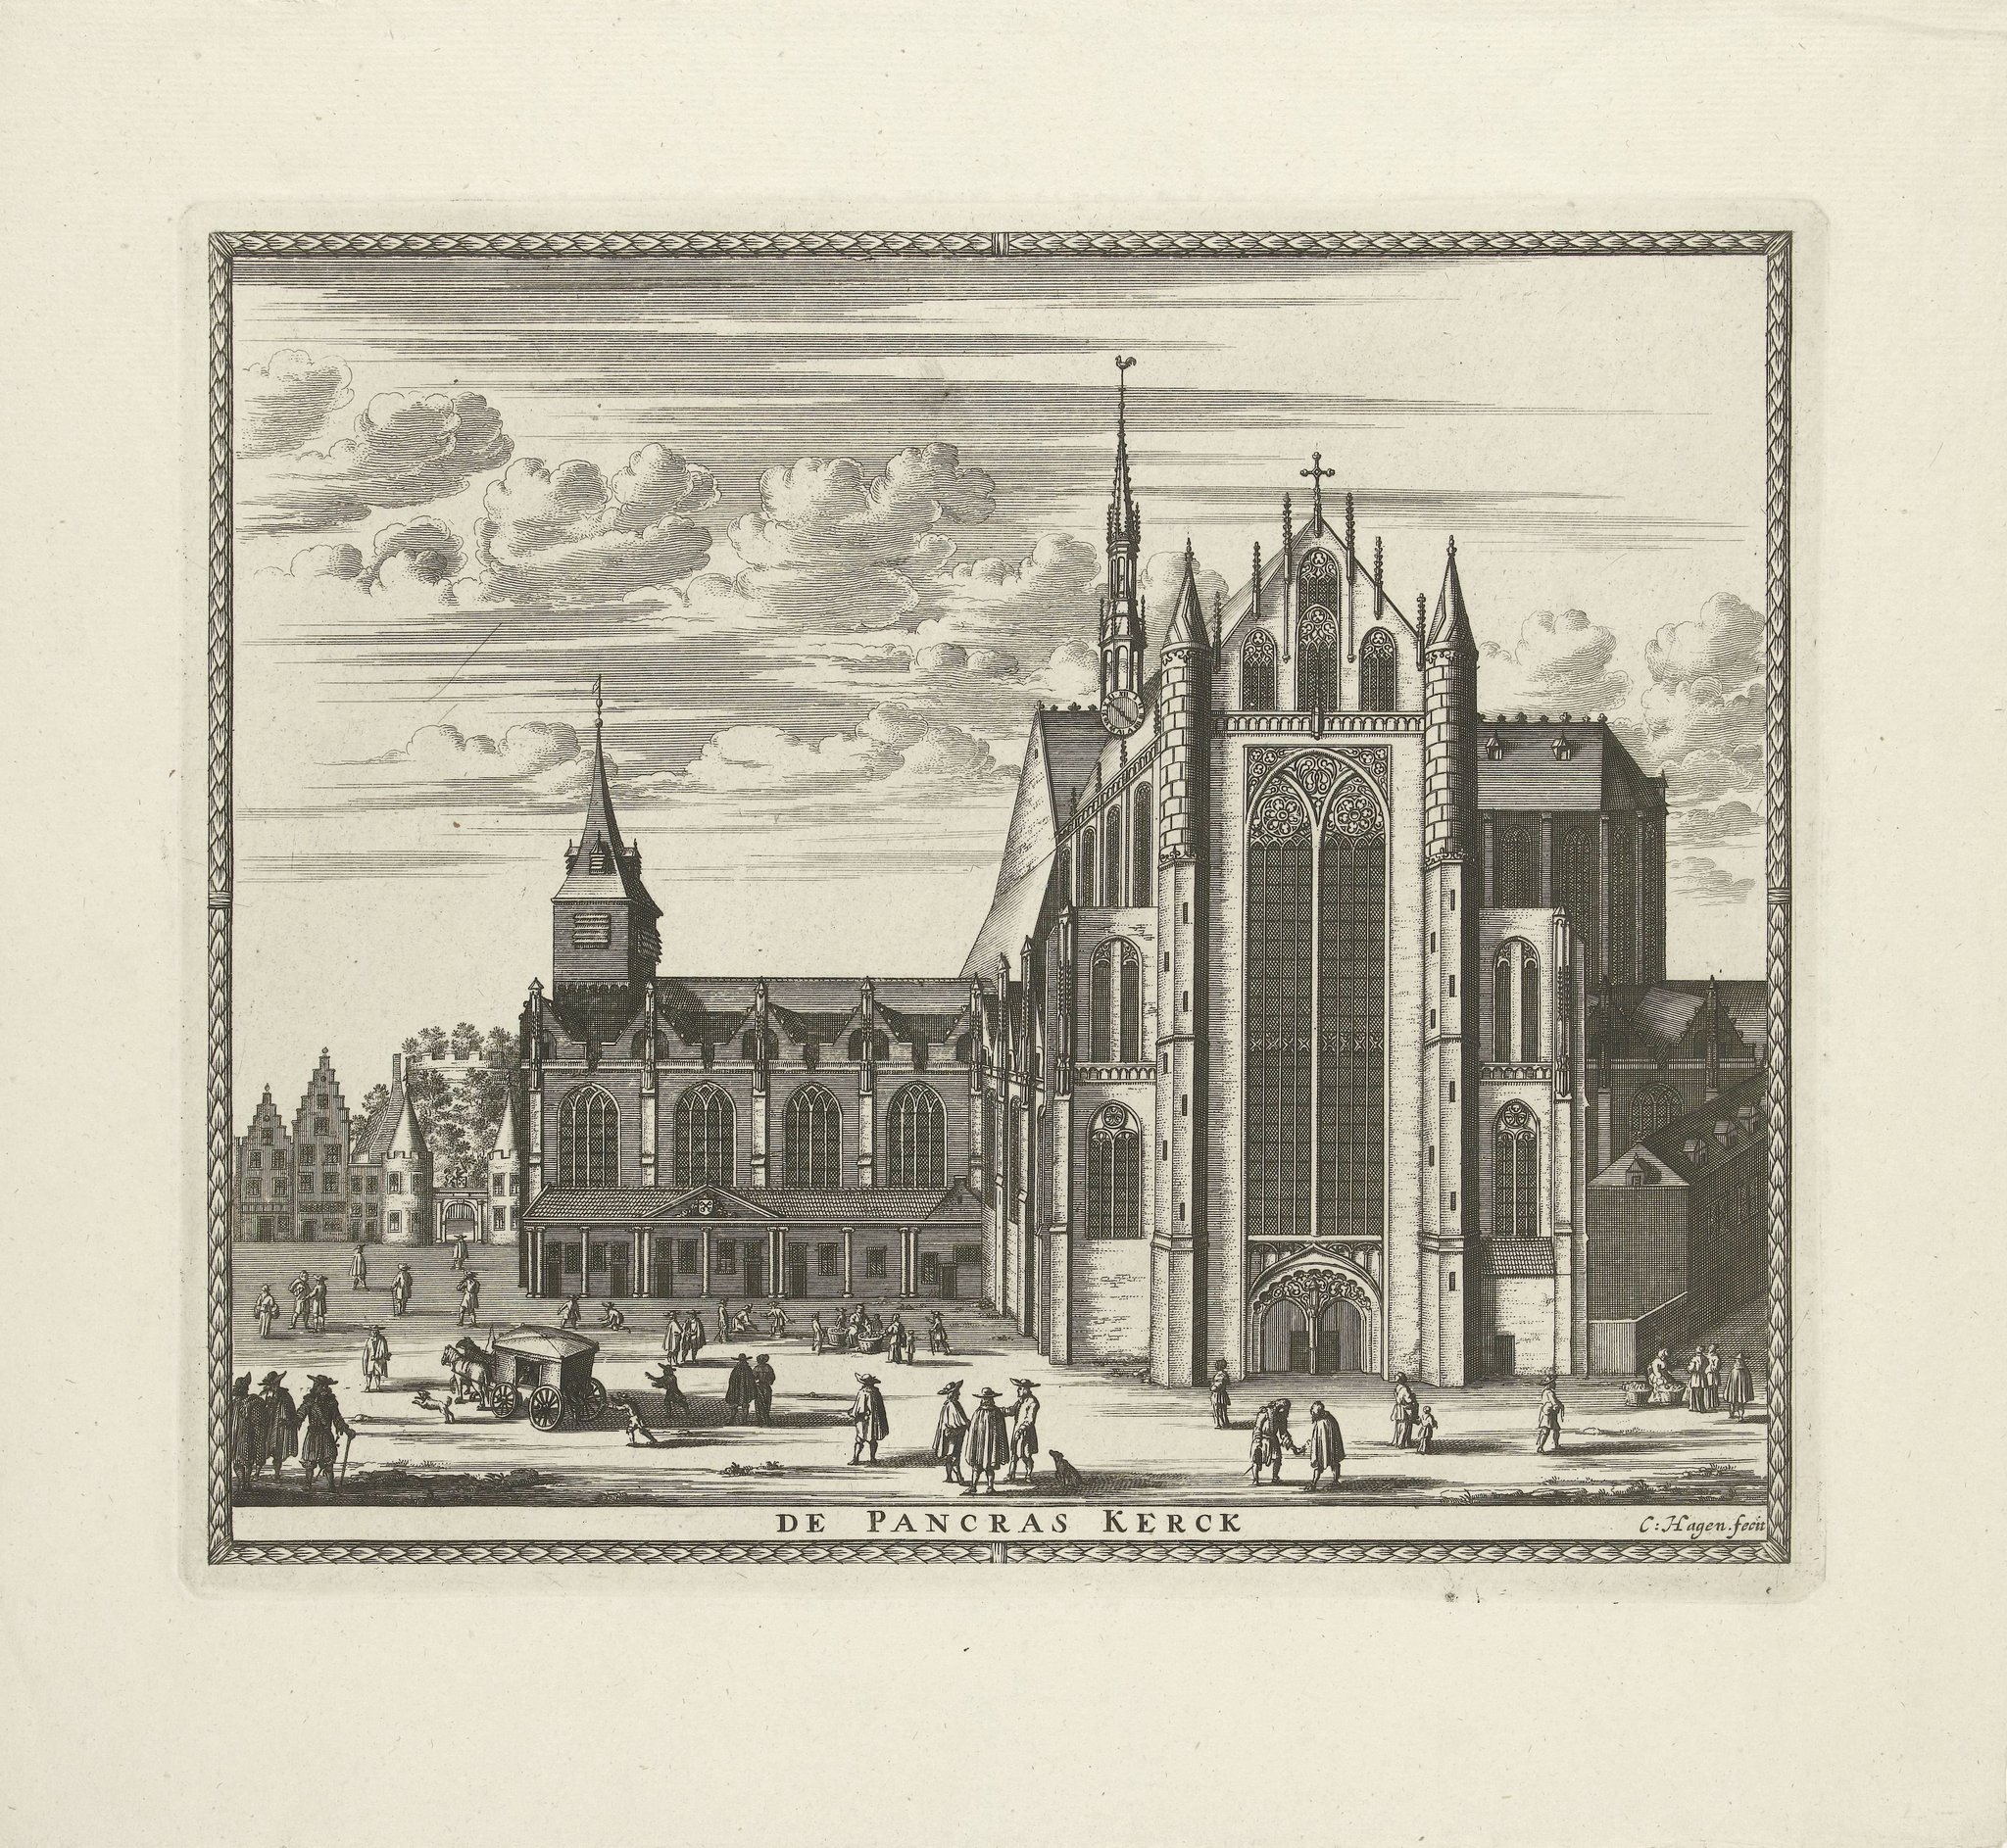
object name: print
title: Gezicht op de Hooglandse kerk (Sint-Pancraskerk) te Leiden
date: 1675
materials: paper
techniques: engraving, etching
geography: amsterdam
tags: church (exterior), city-view, and landscape with man-made constructions (+ city(-scape) with figures, staffage)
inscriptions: collector's mark: Lugt 2760, collector's mark: Lugt 2228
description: Deze prent is oorspronkelijk bedoeld als onderdeel van de rand van de zogenaamde Grote Hagen, een wandkaart van Leiden uit 1675. Deze wandkaart bestaat uit een plattegrond van Leiden met daaromheen een rand (met boven de titel en de wapens van de stad en de burgemeesters, langs de zijkanten afbeeldingen van gebouwen in de stad en onder een stadsprofiel). De plattegrond is gedrukt van vier platen, de rand van veertien. Waar en op welke zijkant deze prent precies hoorde is onbekend omdat onduidelijk is wat de beoogde volgorde was. Er zijn verschillende gemonteerde exemplaren bekend die allen een andere volgorde aanhouden. Hoewel het jaartal 1670 in de titel staat en de wapens aan de bovenkant van de vier in 1670 zittende burgemeesters zijn, blijkt uit archiefonderzoek dat deze wandkaart pas in 1675 voor het eerst is gedrukt en uitgegeven (zie documentatie voor meer informatie). Voor een digitaal gemonteerde versie van de hele rand zie RP-P-2016-1124. Voor een digitaal gemonteerde versie van de bovenkant van de rand zie RP-P-AO-10-18A-A. Voor een digitaal gemonteerde versie van de onderkant van de rand zie RP-P-AO-10-18A-B. Voor een digitaal gemonteerde versie van een latere druk van de plattegrond zie RP-P-AO-10-18. Voor een digitaal gemonteerde versie van de Kleine Hagen zie RP-P-AO-10-81.